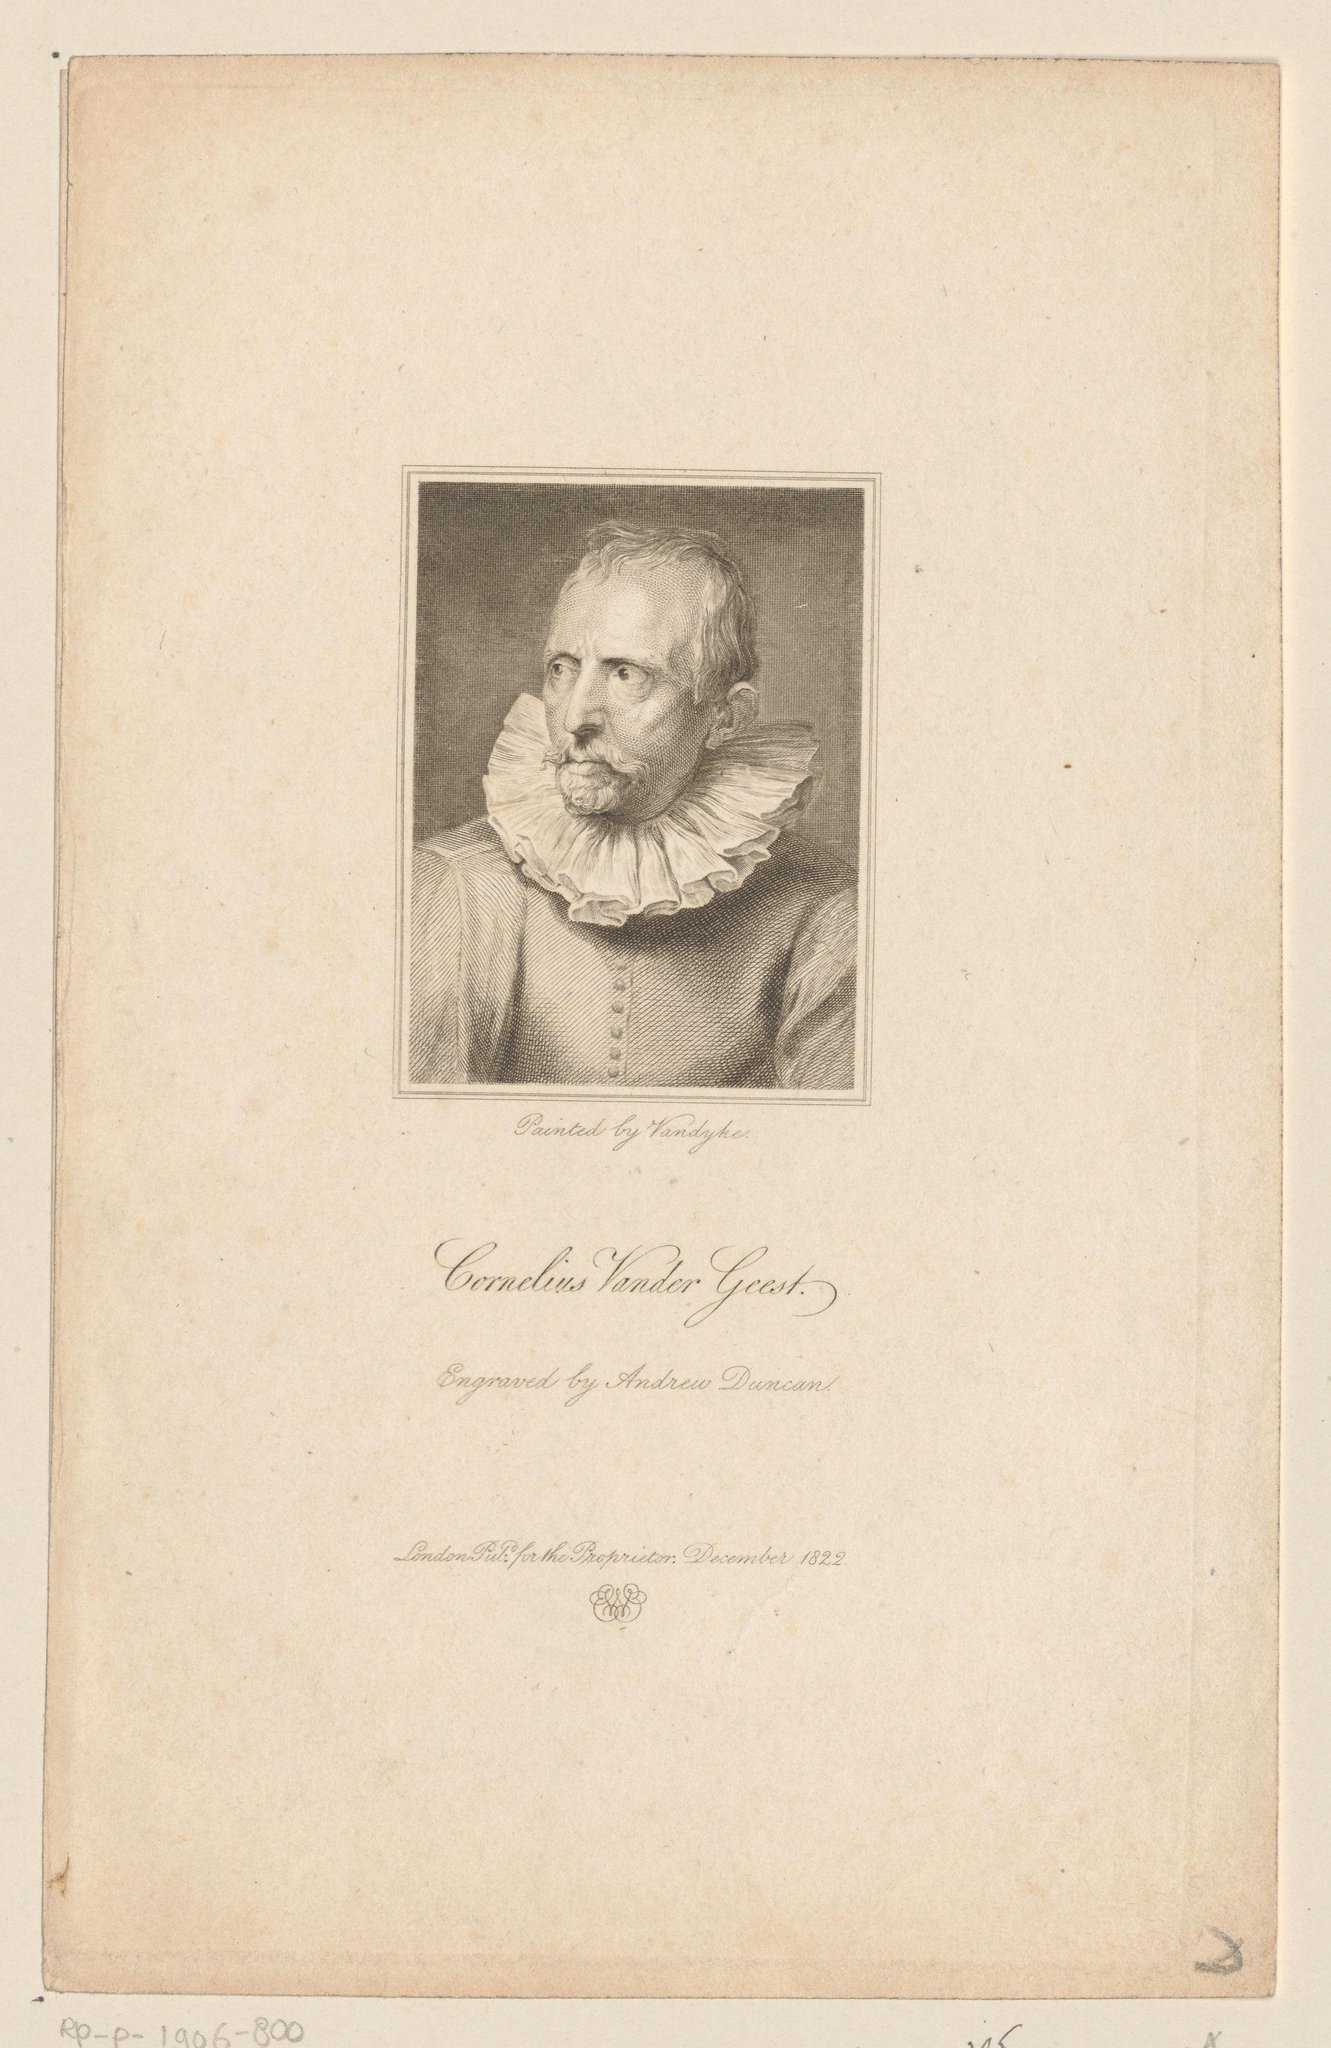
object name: print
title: Portret van Cornelis van der Geest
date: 1812-1822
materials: paper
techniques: engraving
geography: london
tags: cornelis van der geest, historical persons, art collector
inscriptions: collector's mark: Lugt 2228